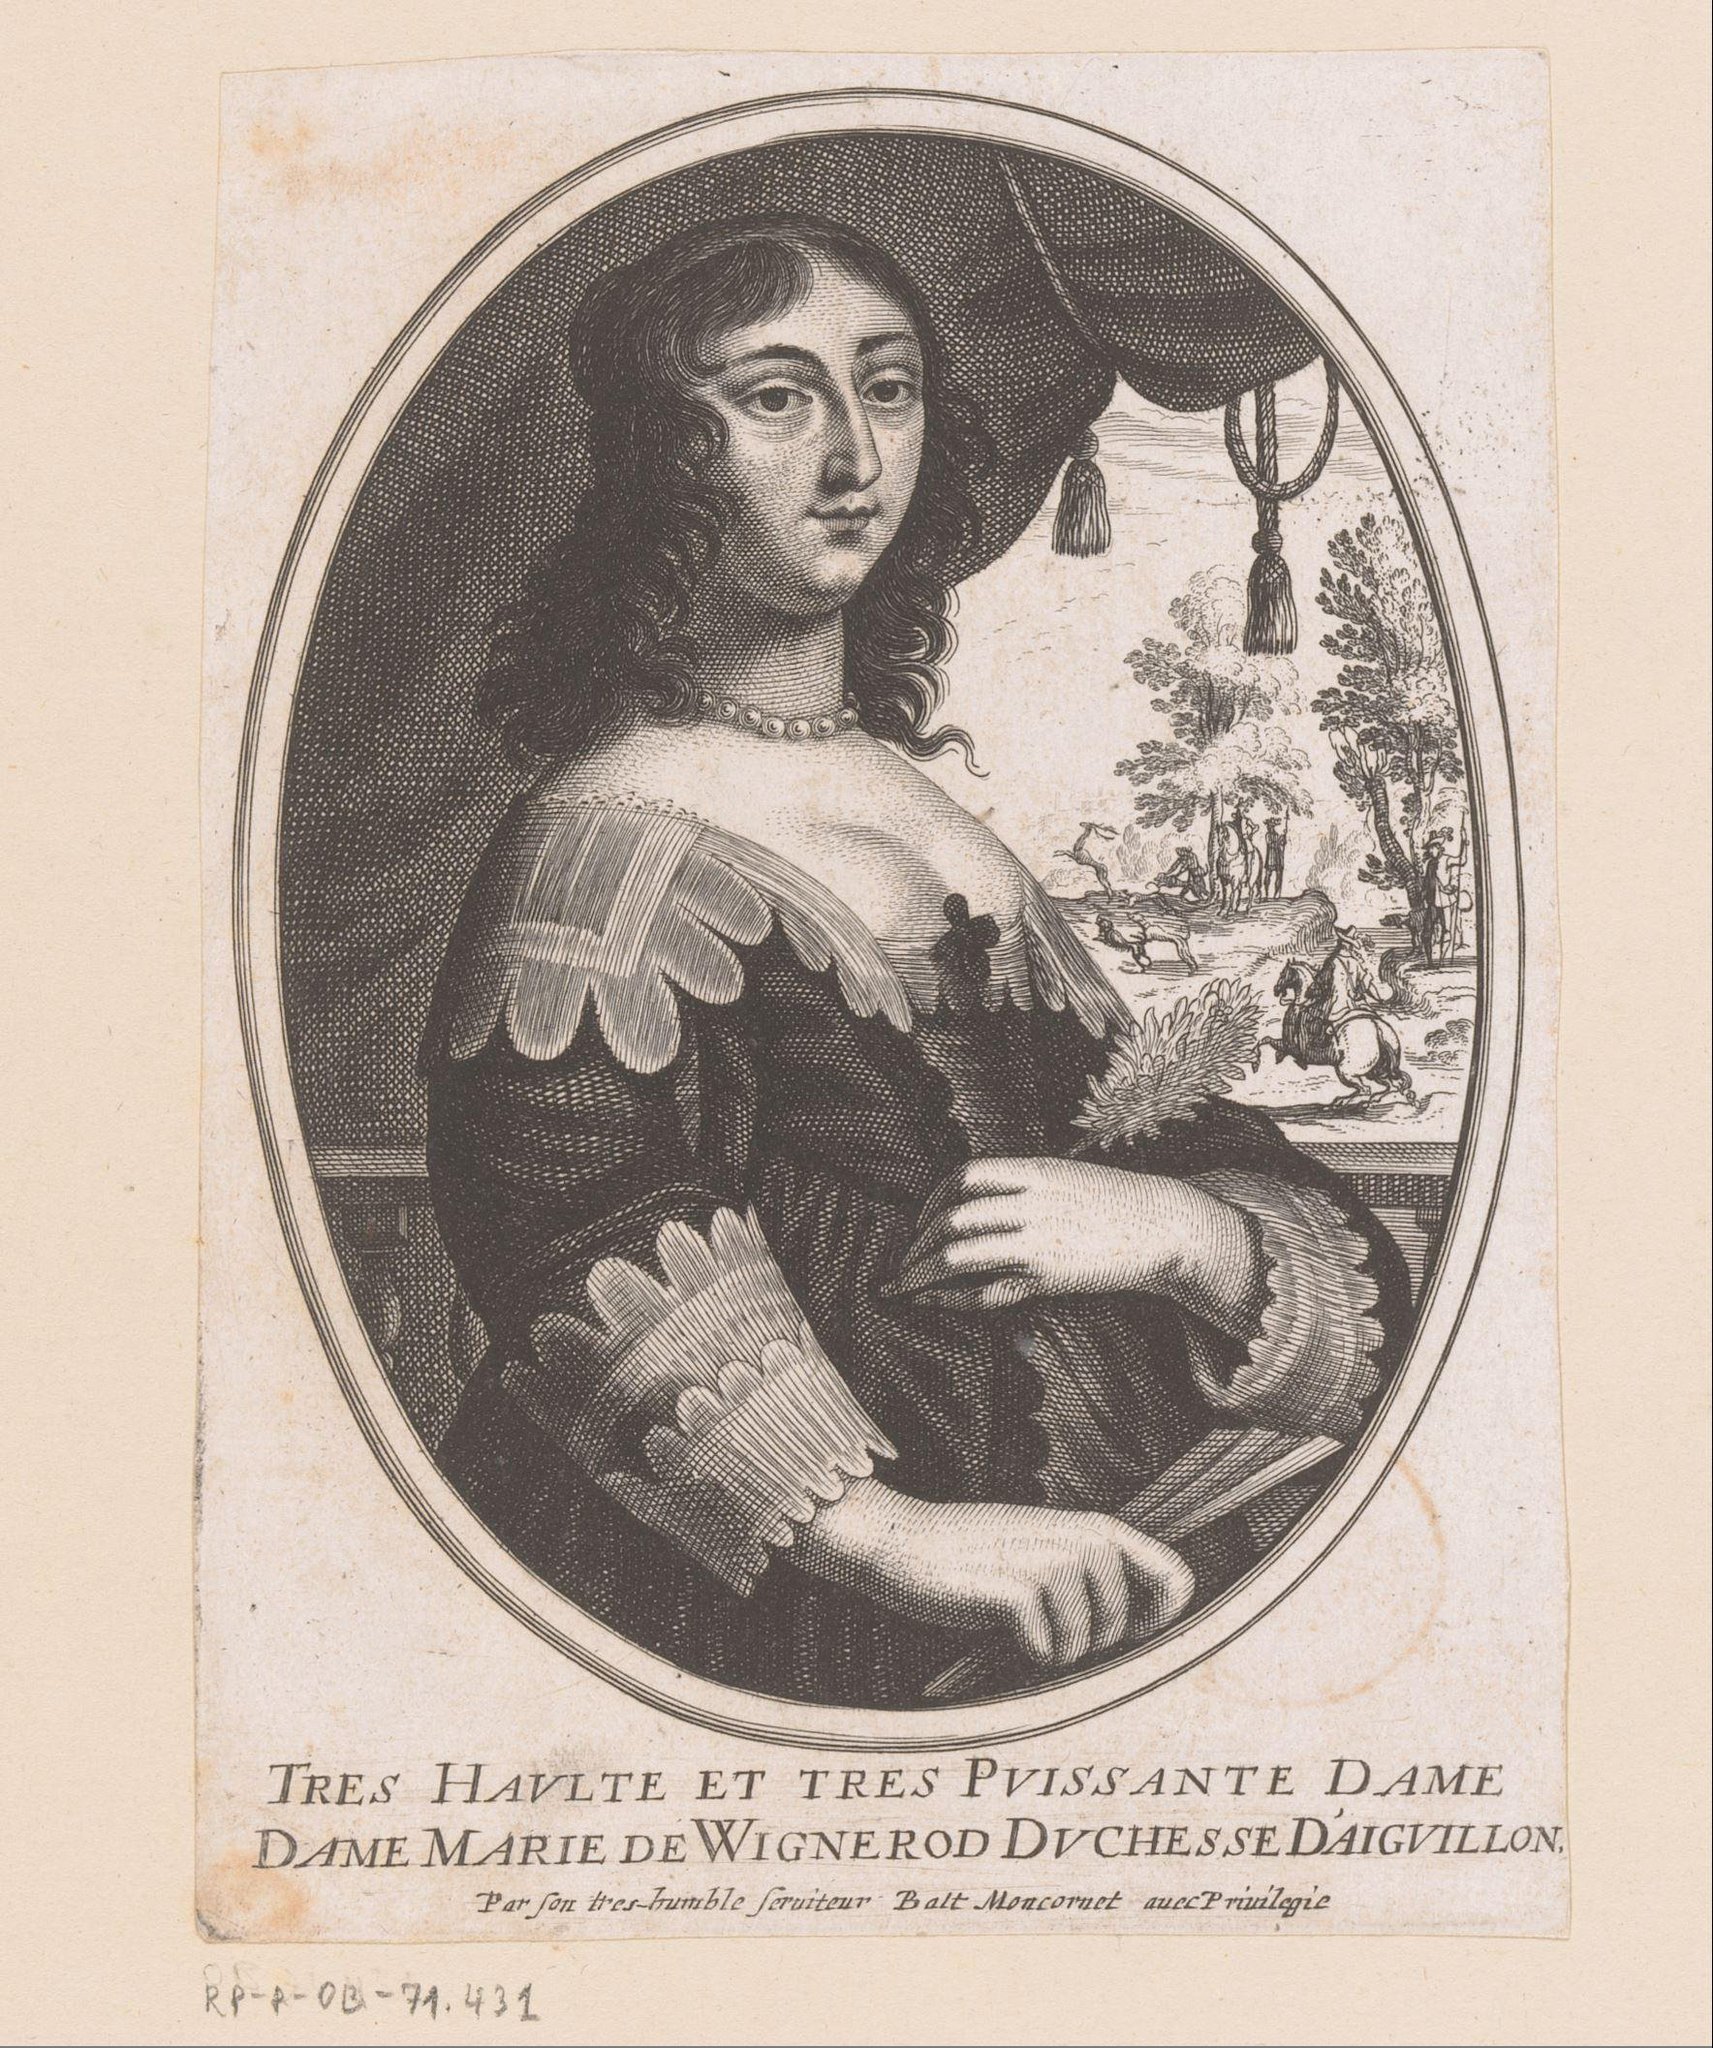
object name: print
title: Portret van Marie Madeleine d'Aiguillon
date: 1619-1668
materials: paper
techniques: engraving, etching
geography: paris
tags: marie madeleine de vignerot hertogin van aiguillon, historical persons - bb - woman, nobility and patriciate; chivalry, knighthood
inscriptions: collector's mark: Lugt 240